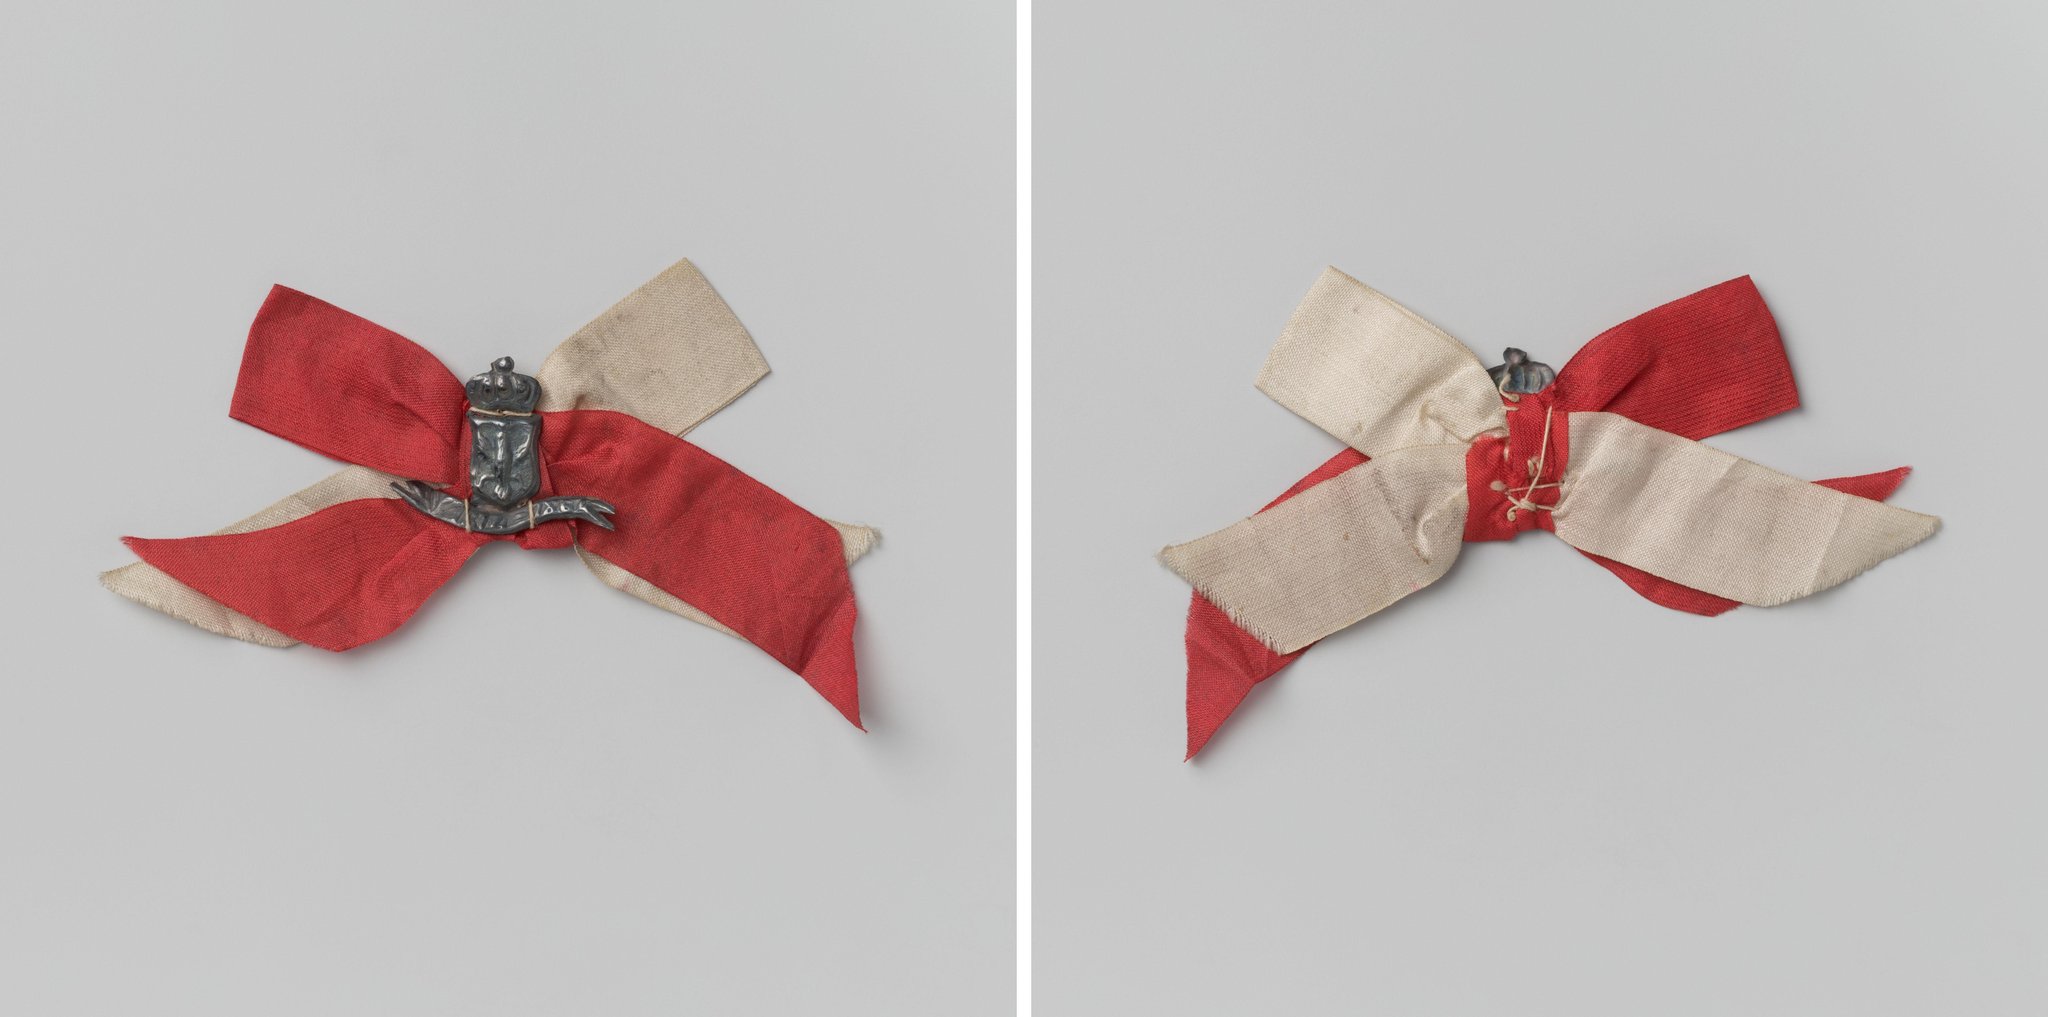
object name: insignia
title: Vijftigjarige viering van de bevrijding van Deventer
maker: Anonymous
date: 1864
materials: silver, textile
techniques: striking, weave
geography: netherlands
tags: deventer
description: Eenzijdig zilveren draagteken aan rood-witte strik; daaraan: gekroond wapenschild boven lint met jaartallen